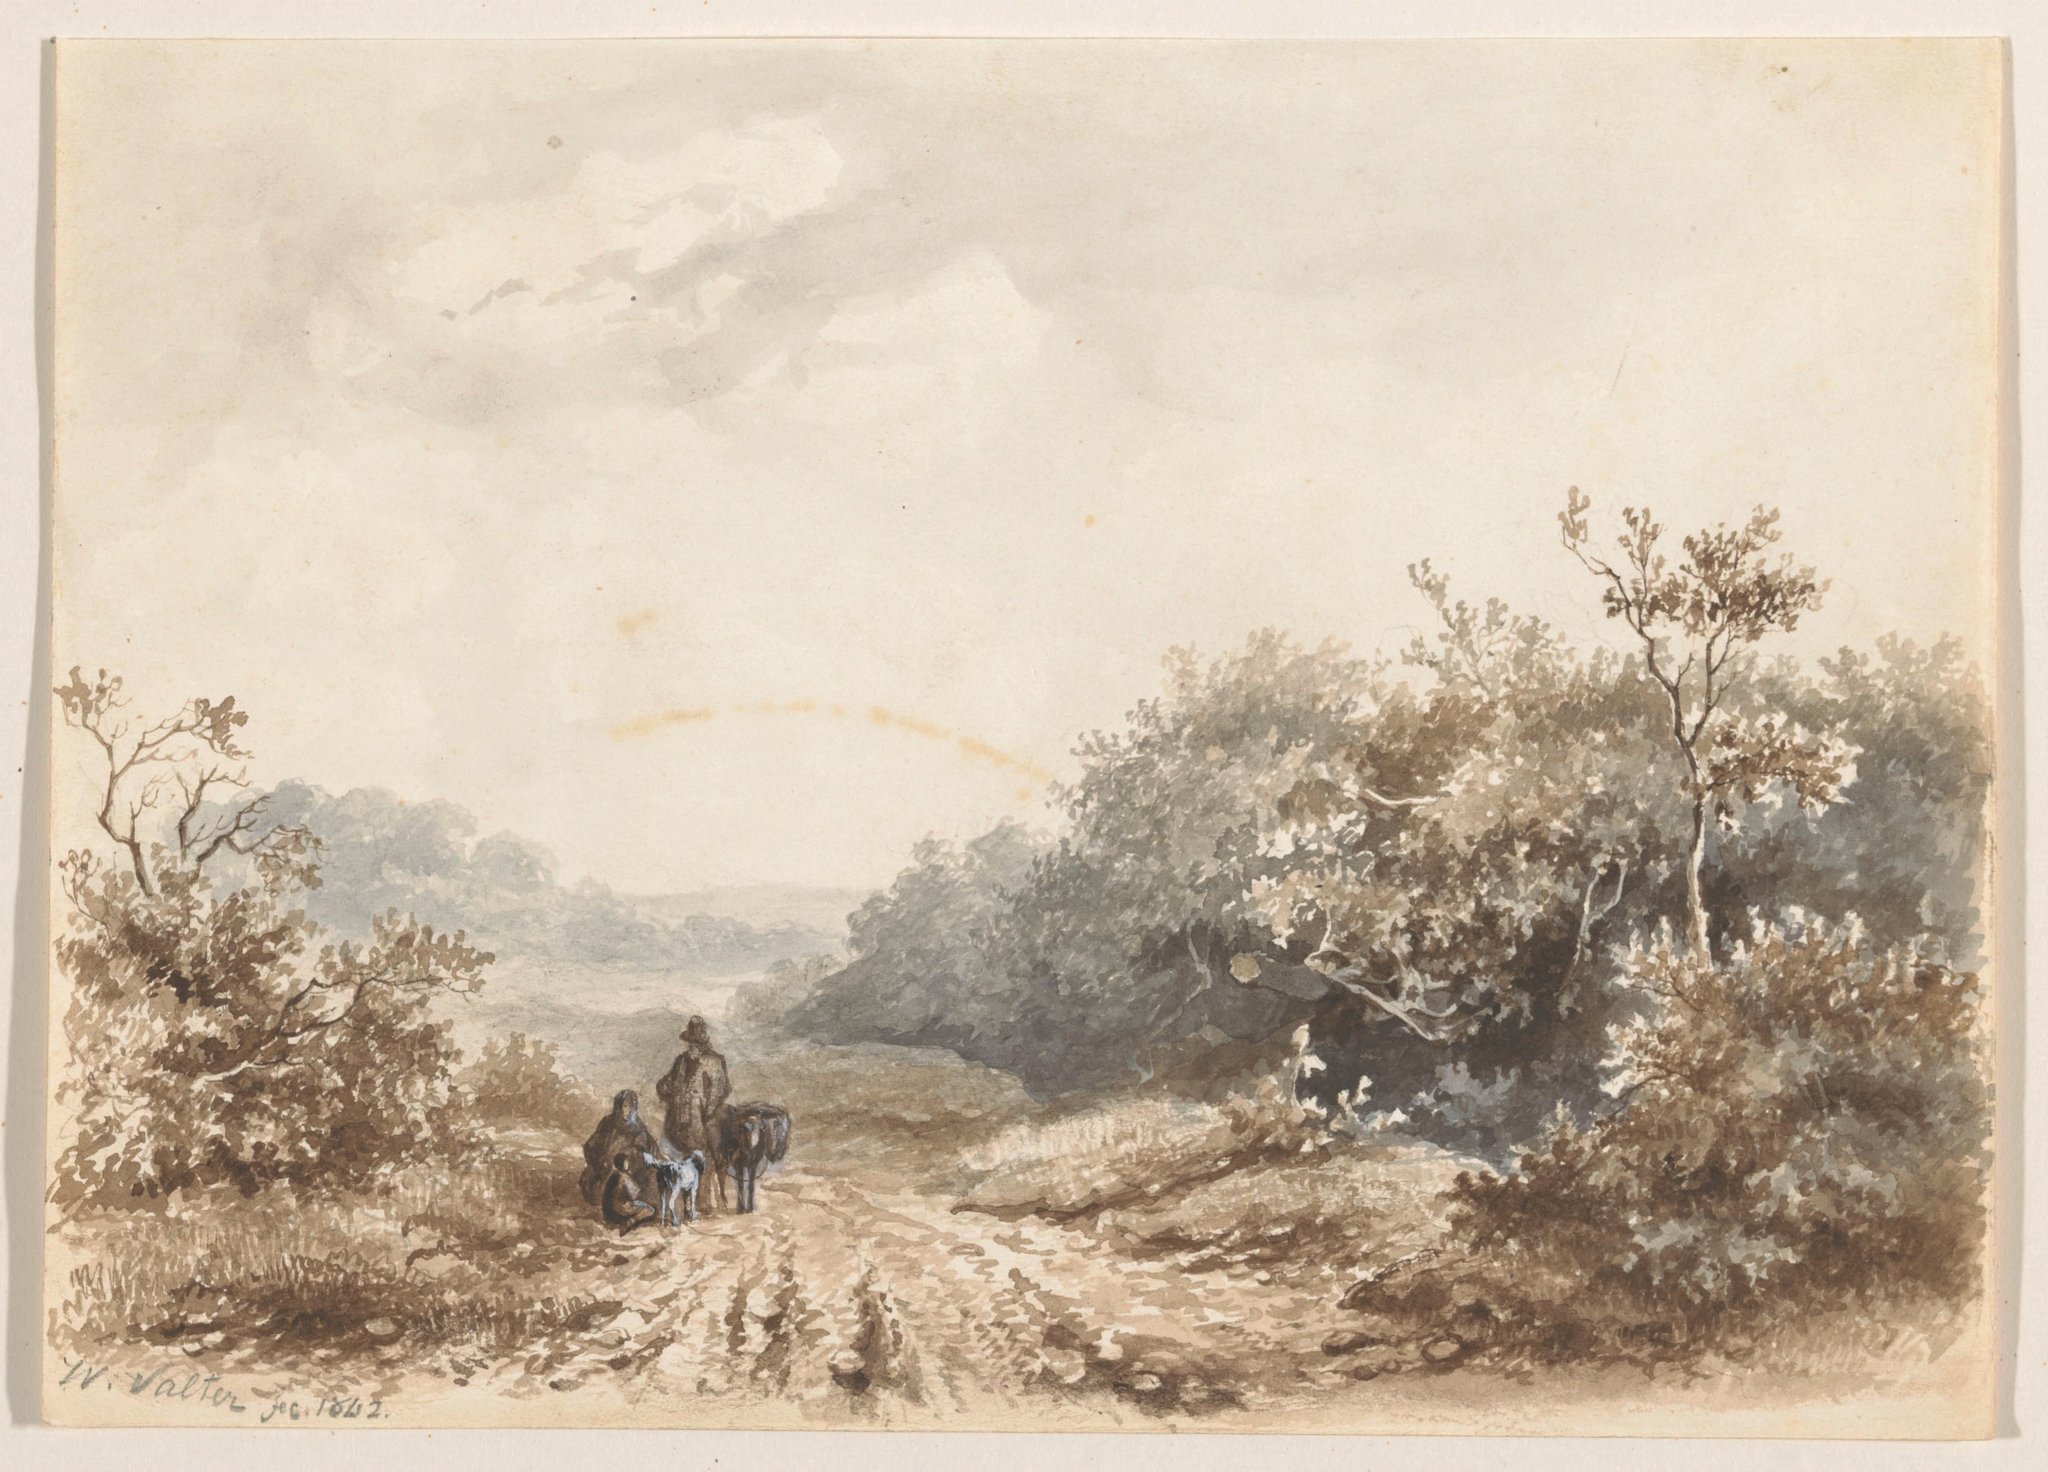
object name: watercolor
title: Landschap met een familie, een schaap en een hond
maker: willem valter pzn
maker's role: draughtsman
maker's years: 1821-1847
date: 1842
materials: paint, paper, pencil, watercolor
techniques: brush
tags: dog